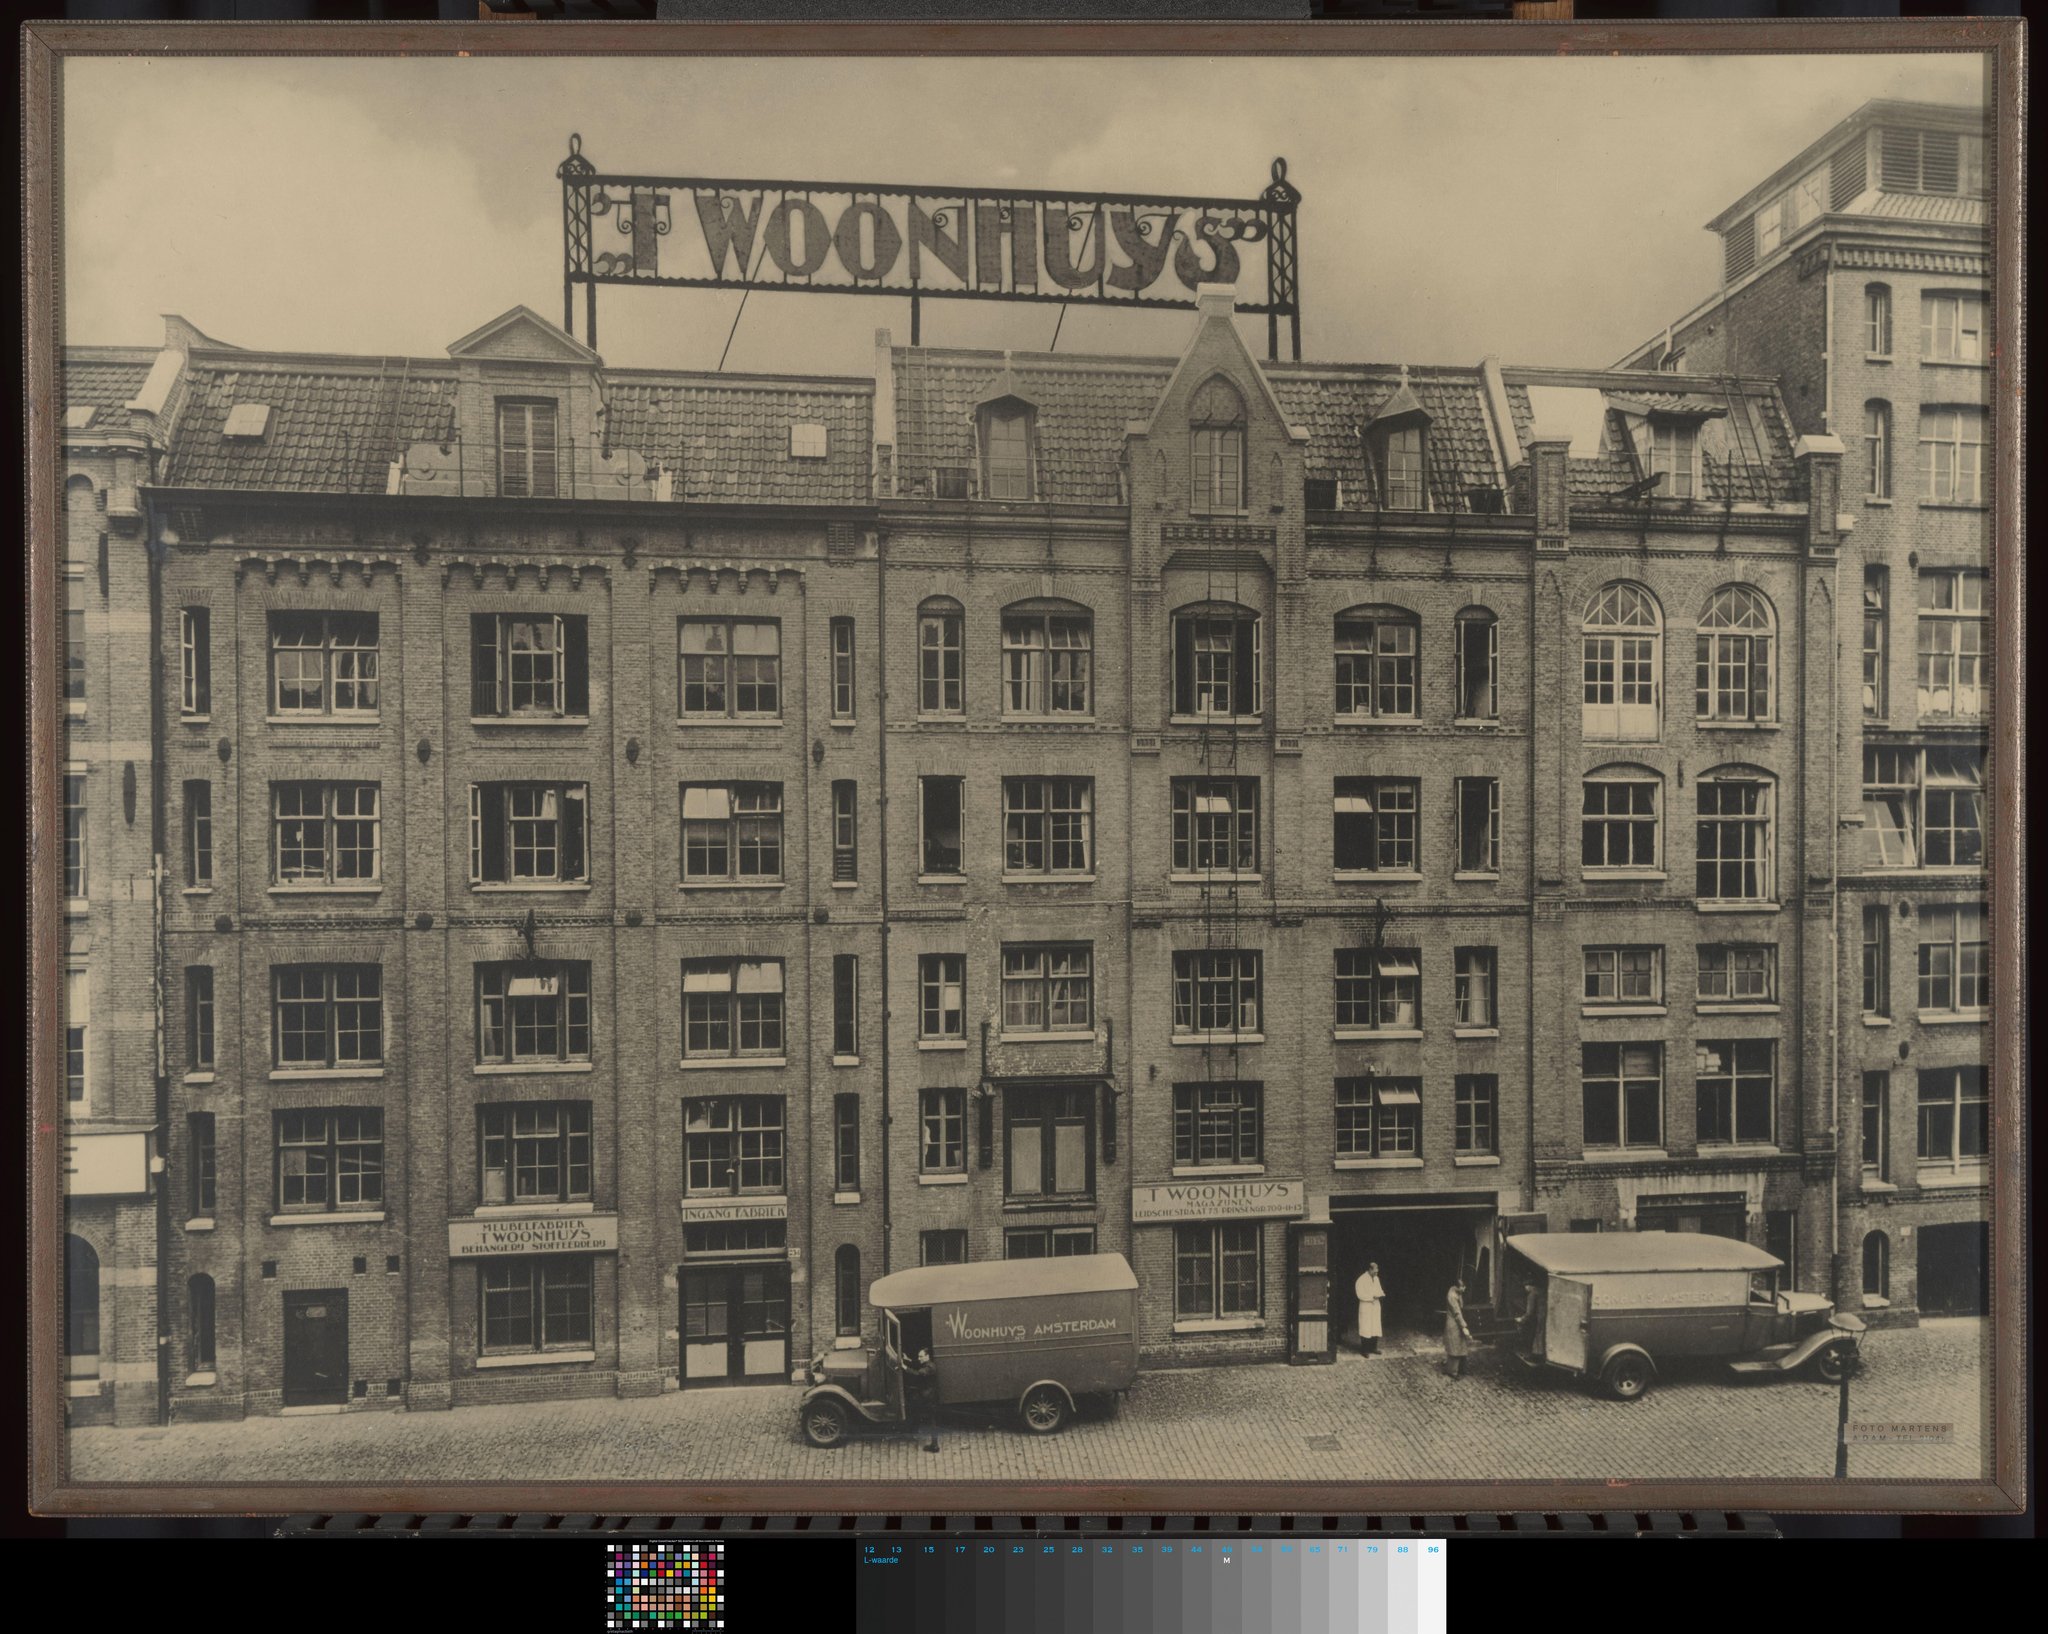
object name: photograph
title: exterieur van de werkplaats (fabriek) van 't Woonhuys, Lijnbaansgracht 234-236, Amsterdam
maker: martens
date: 1925-1940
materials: cardboard, glass, photographic support, wood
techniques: gelatin silver print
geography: amsterdam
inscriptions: label: ‘FOTO MARTENS / A'DAM - TEL. 21046’